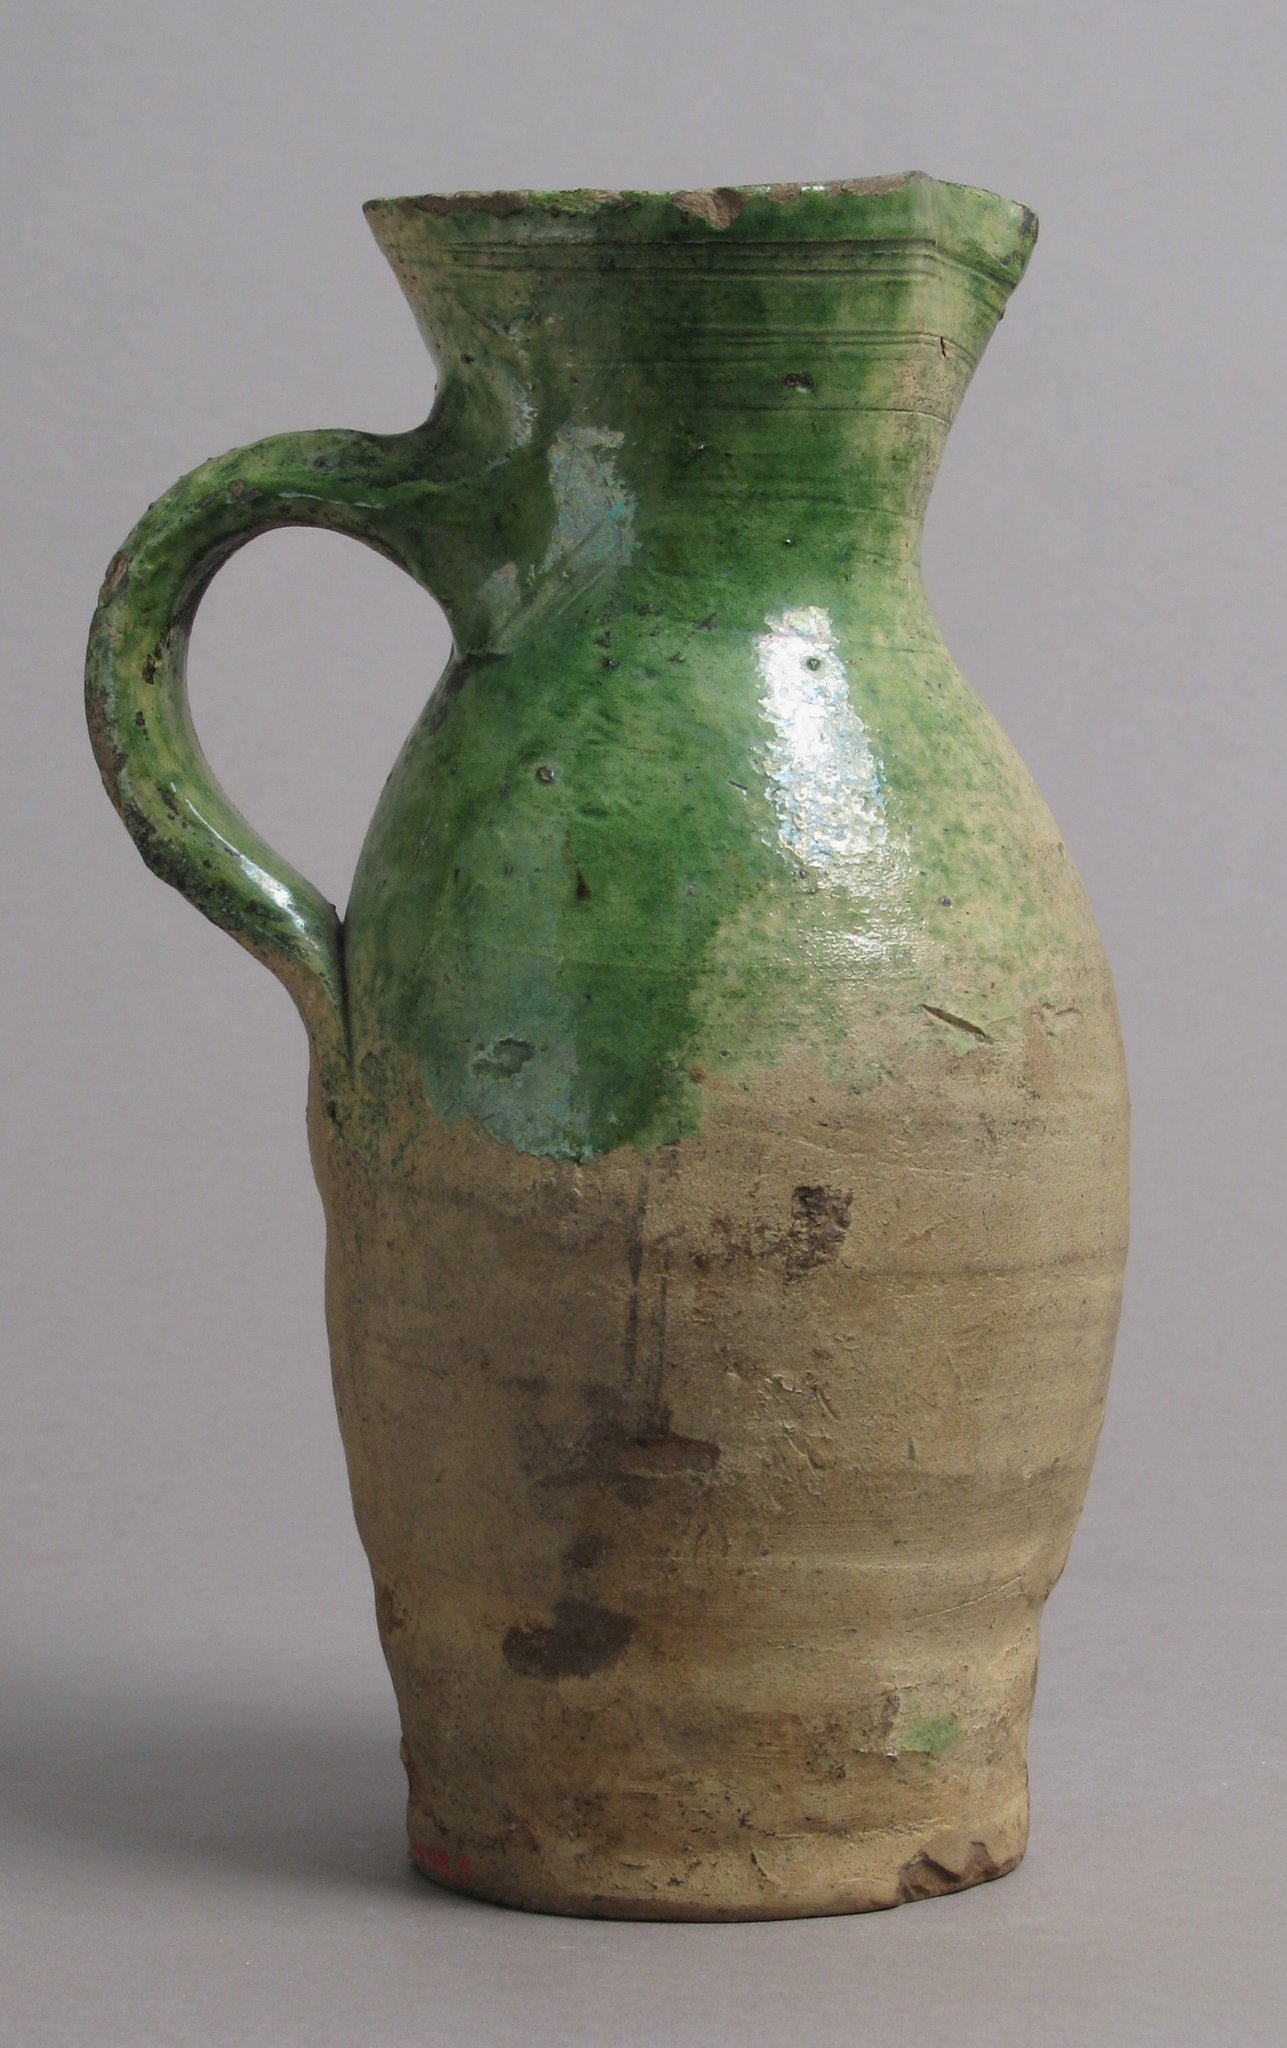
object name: jug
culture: british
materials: earthenware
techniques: glazing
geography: england